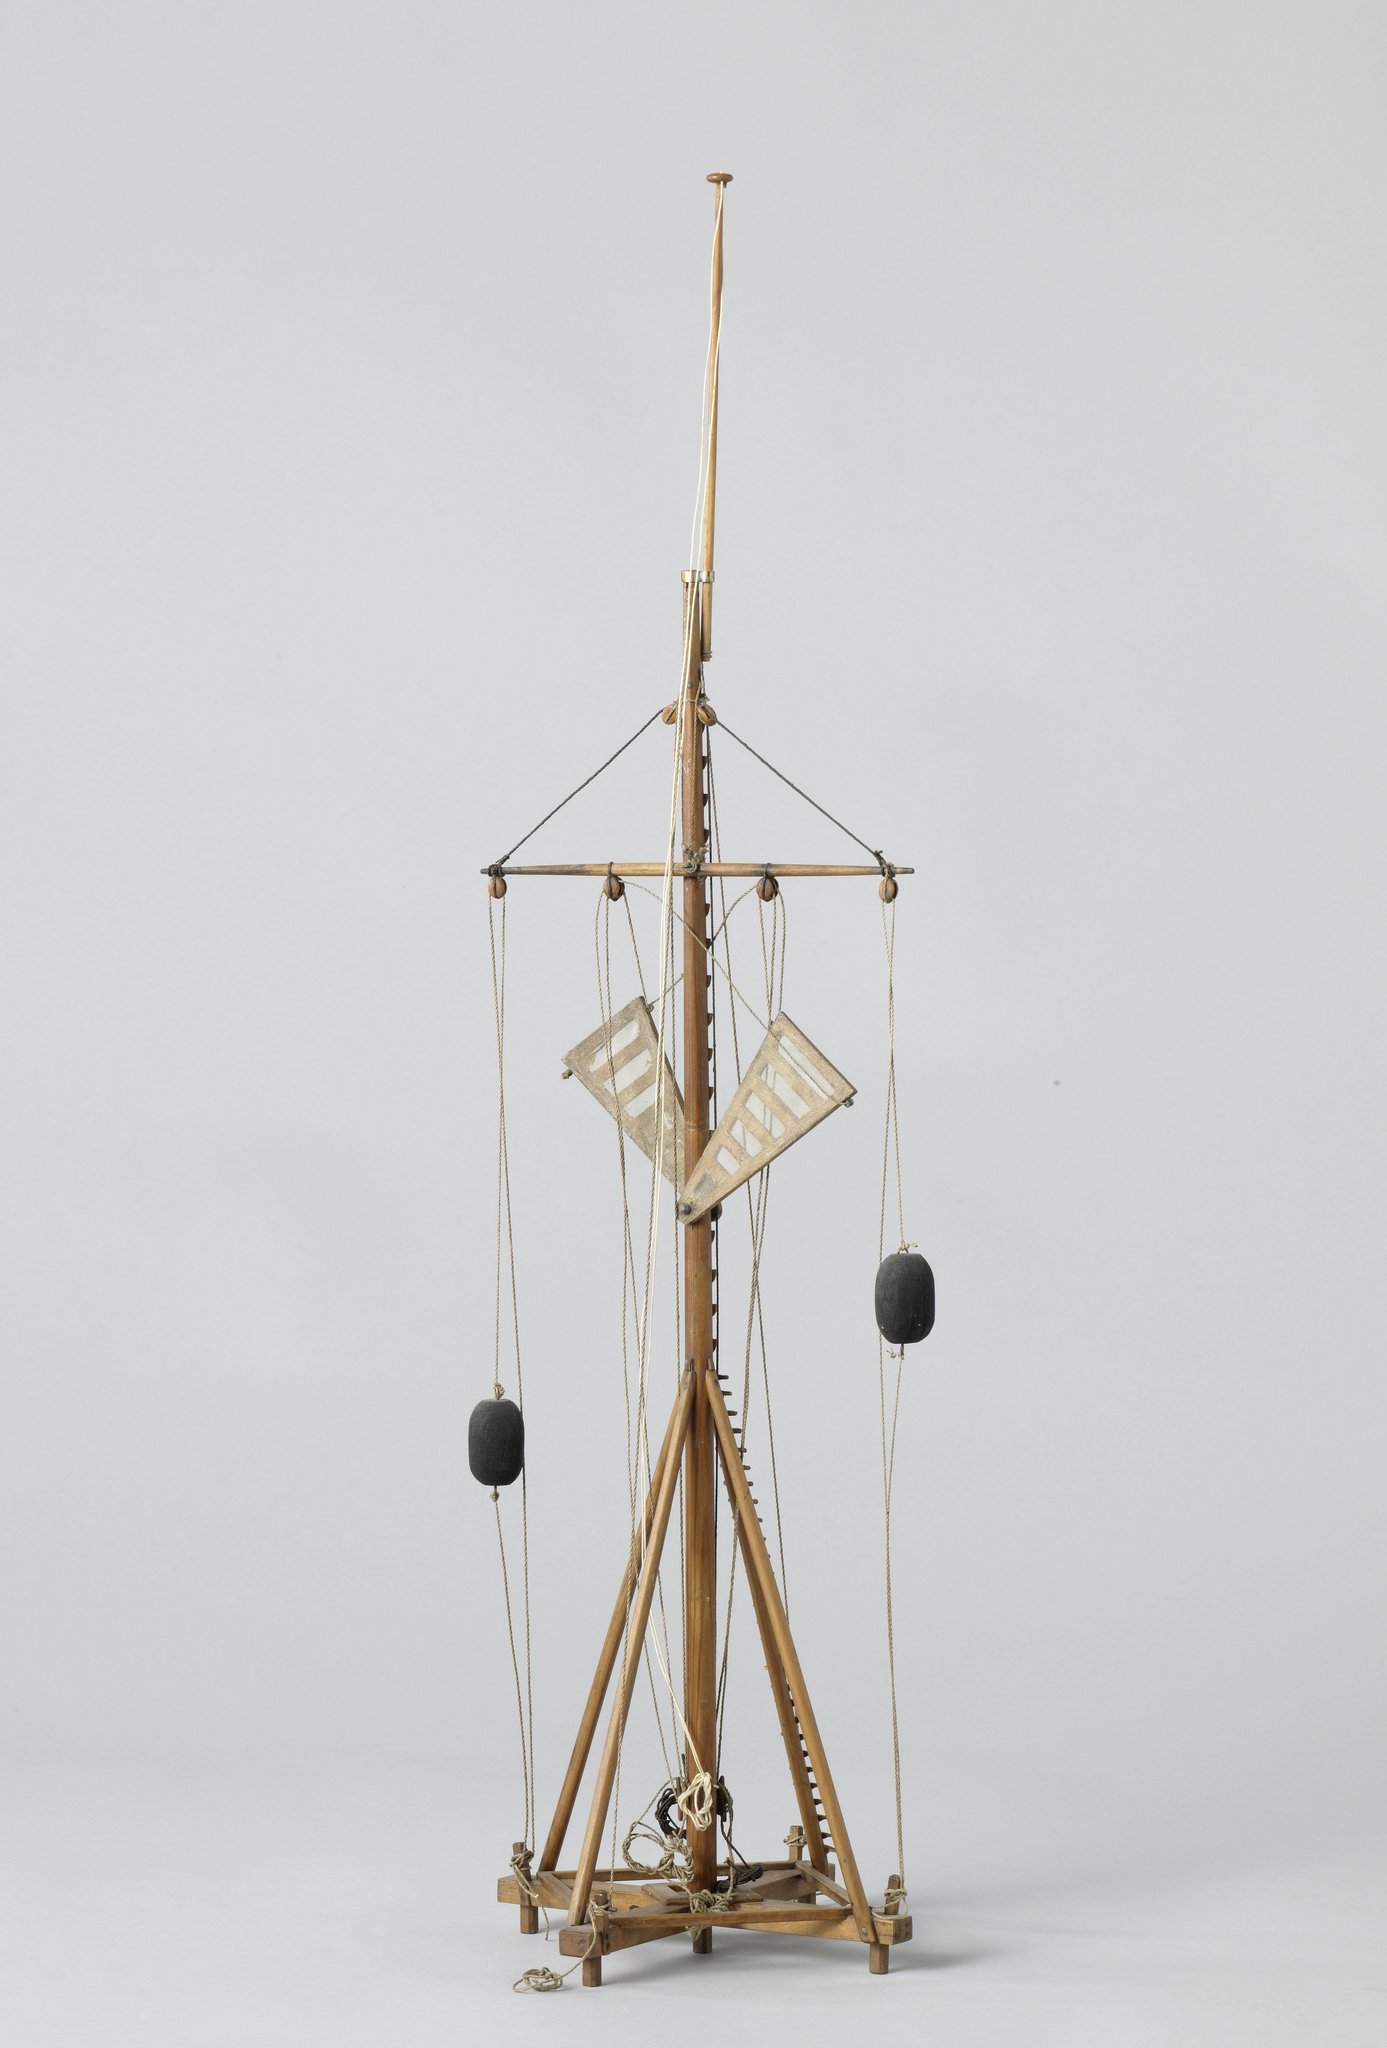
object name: demonstration model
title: Model of a Batavian Coastal Telegraph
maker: Anonymous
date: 1798-1800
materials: brass, fiber, textile, wood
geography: netherlands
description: Batavian coastal telegraph. Model, c. 1799. Between 1798 and 1803 a chain of 63 coastal telegraphs were positioned along the Dutch shore. When in August 1799 British troops were about to land on the Dutch coast, the government in The Hague was kept informed and ready to act. The central nerve of the coastal network was at Seinpostduin in Scheveningen, near the seat of government. The coastal telegraph was about 20 metre high. Signals were relayed with the indicators on the crossbars from one post to the next, at regular eight-kilometre intervals.